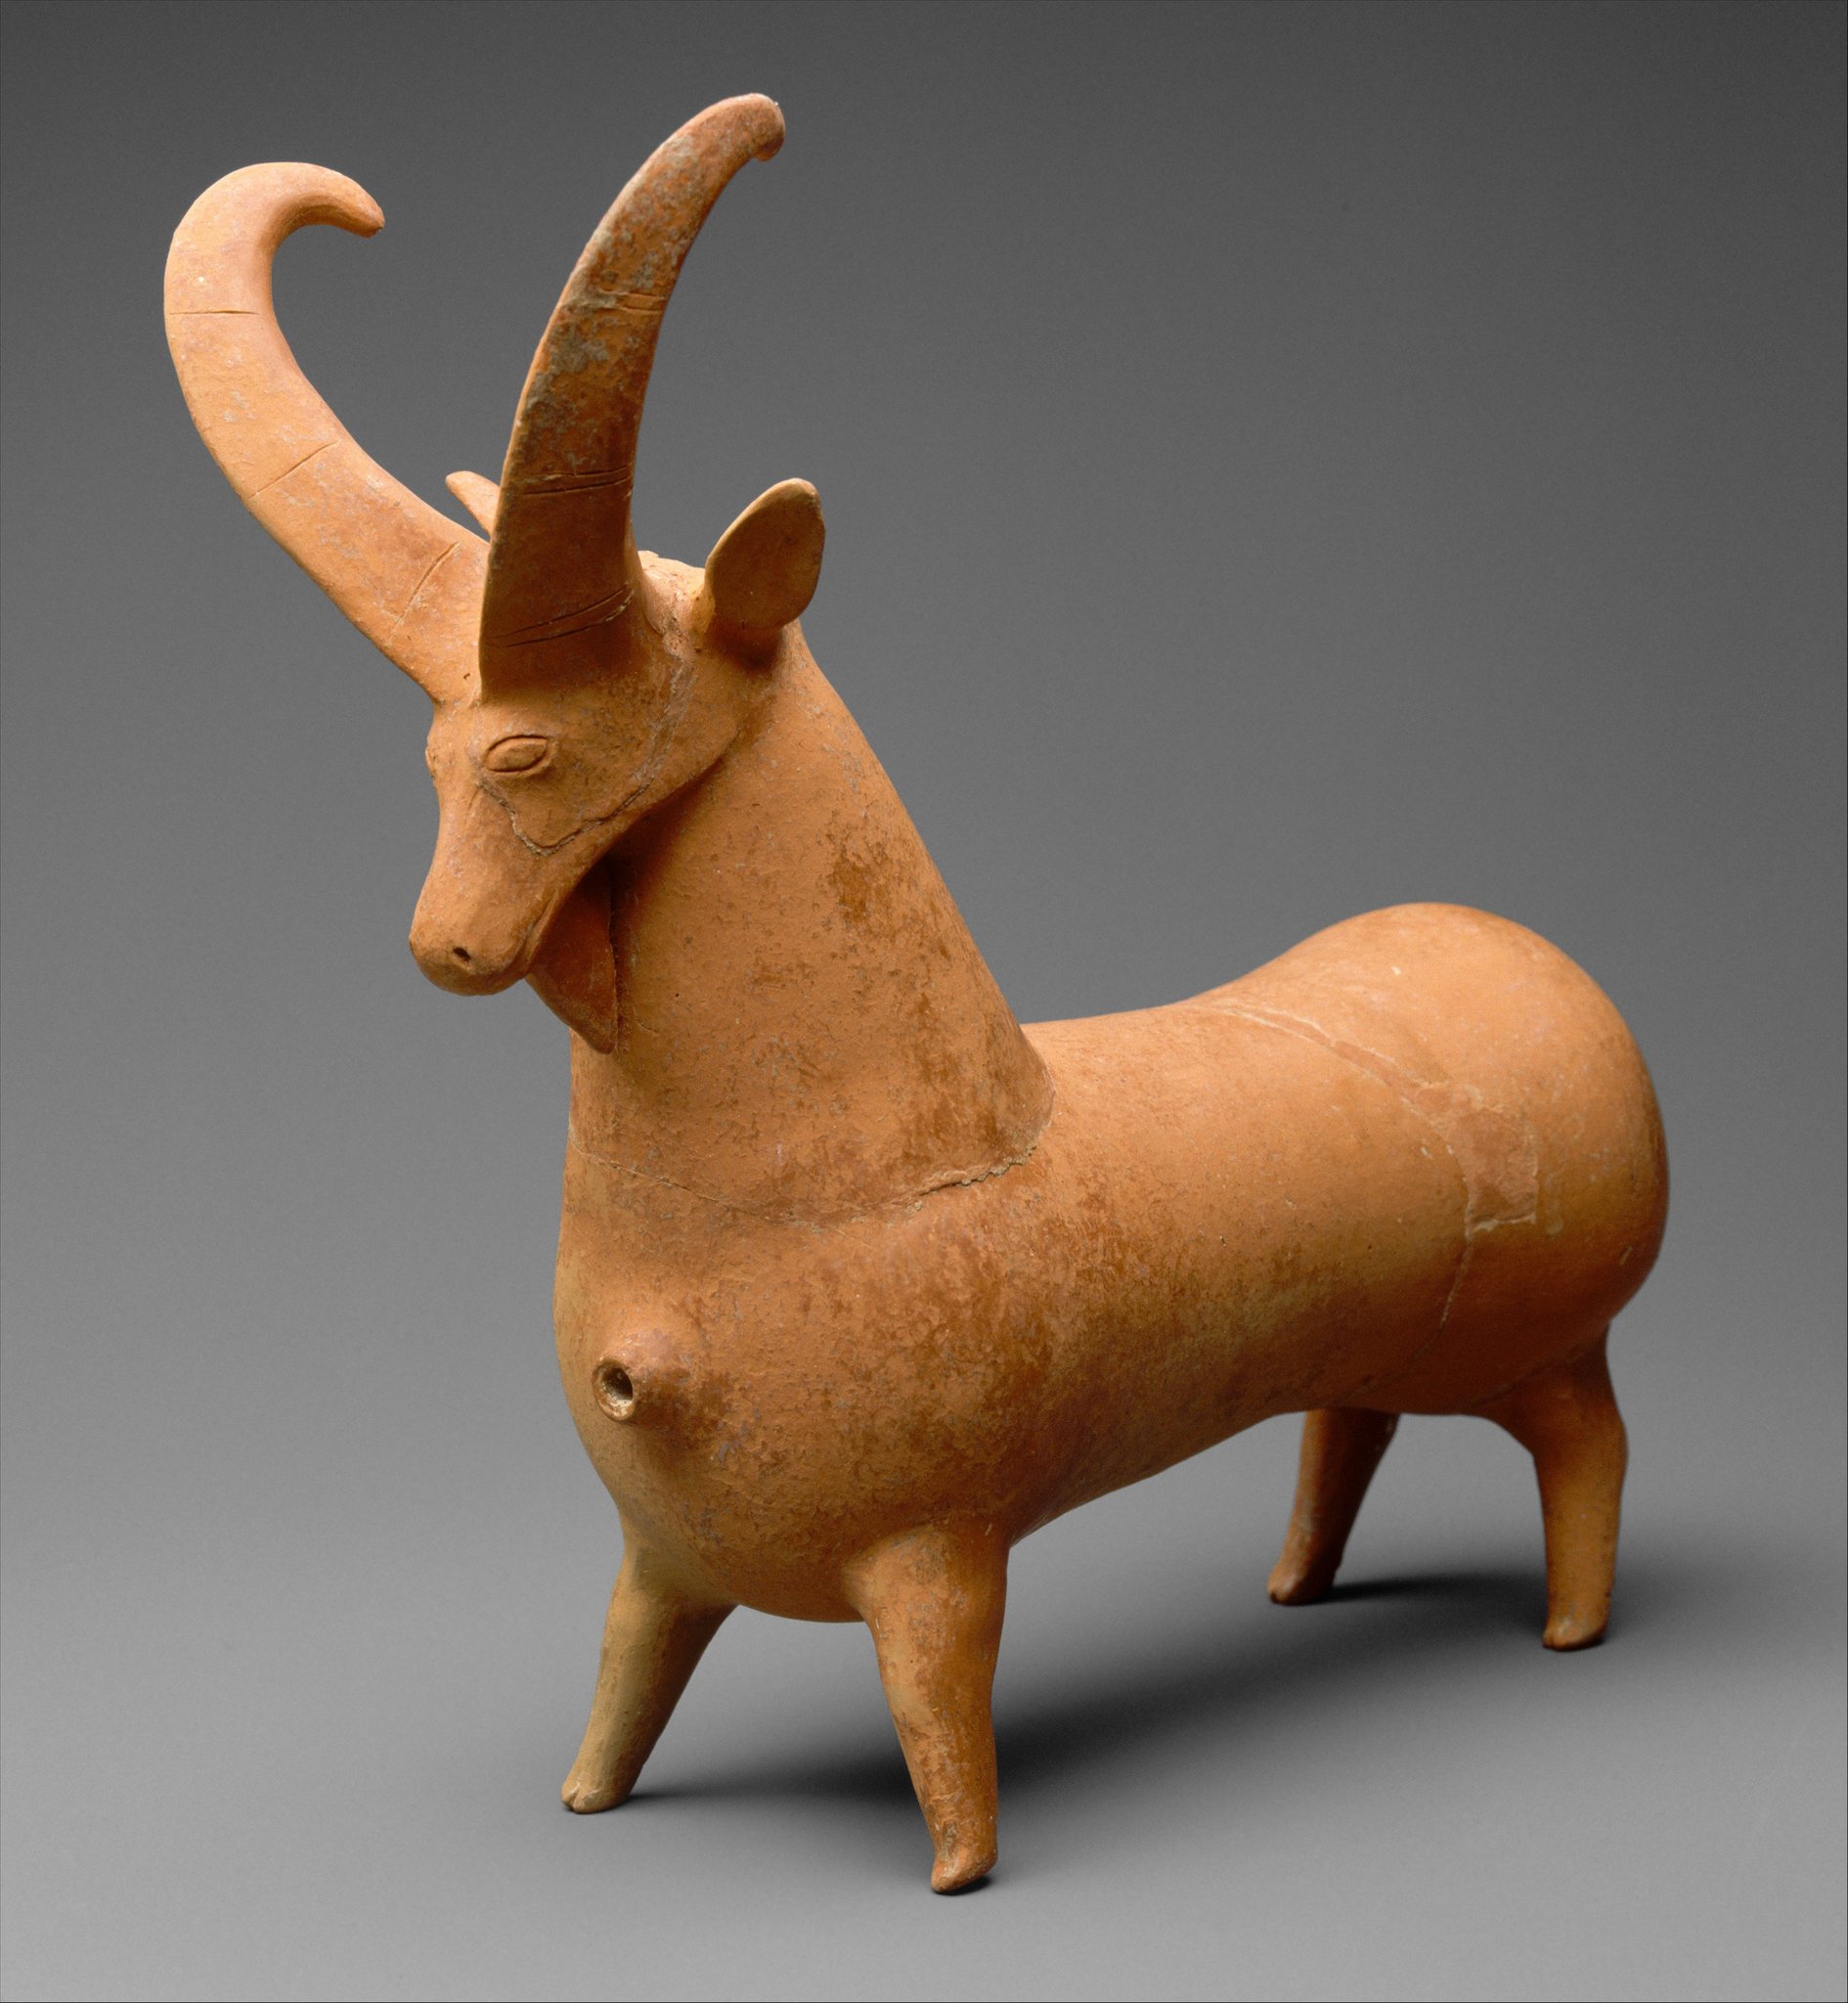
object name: rhyton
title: Rhyton in the shape of an ibex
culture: iranian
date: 500 BCE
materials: ceramic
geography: northwestern iran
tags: ibex